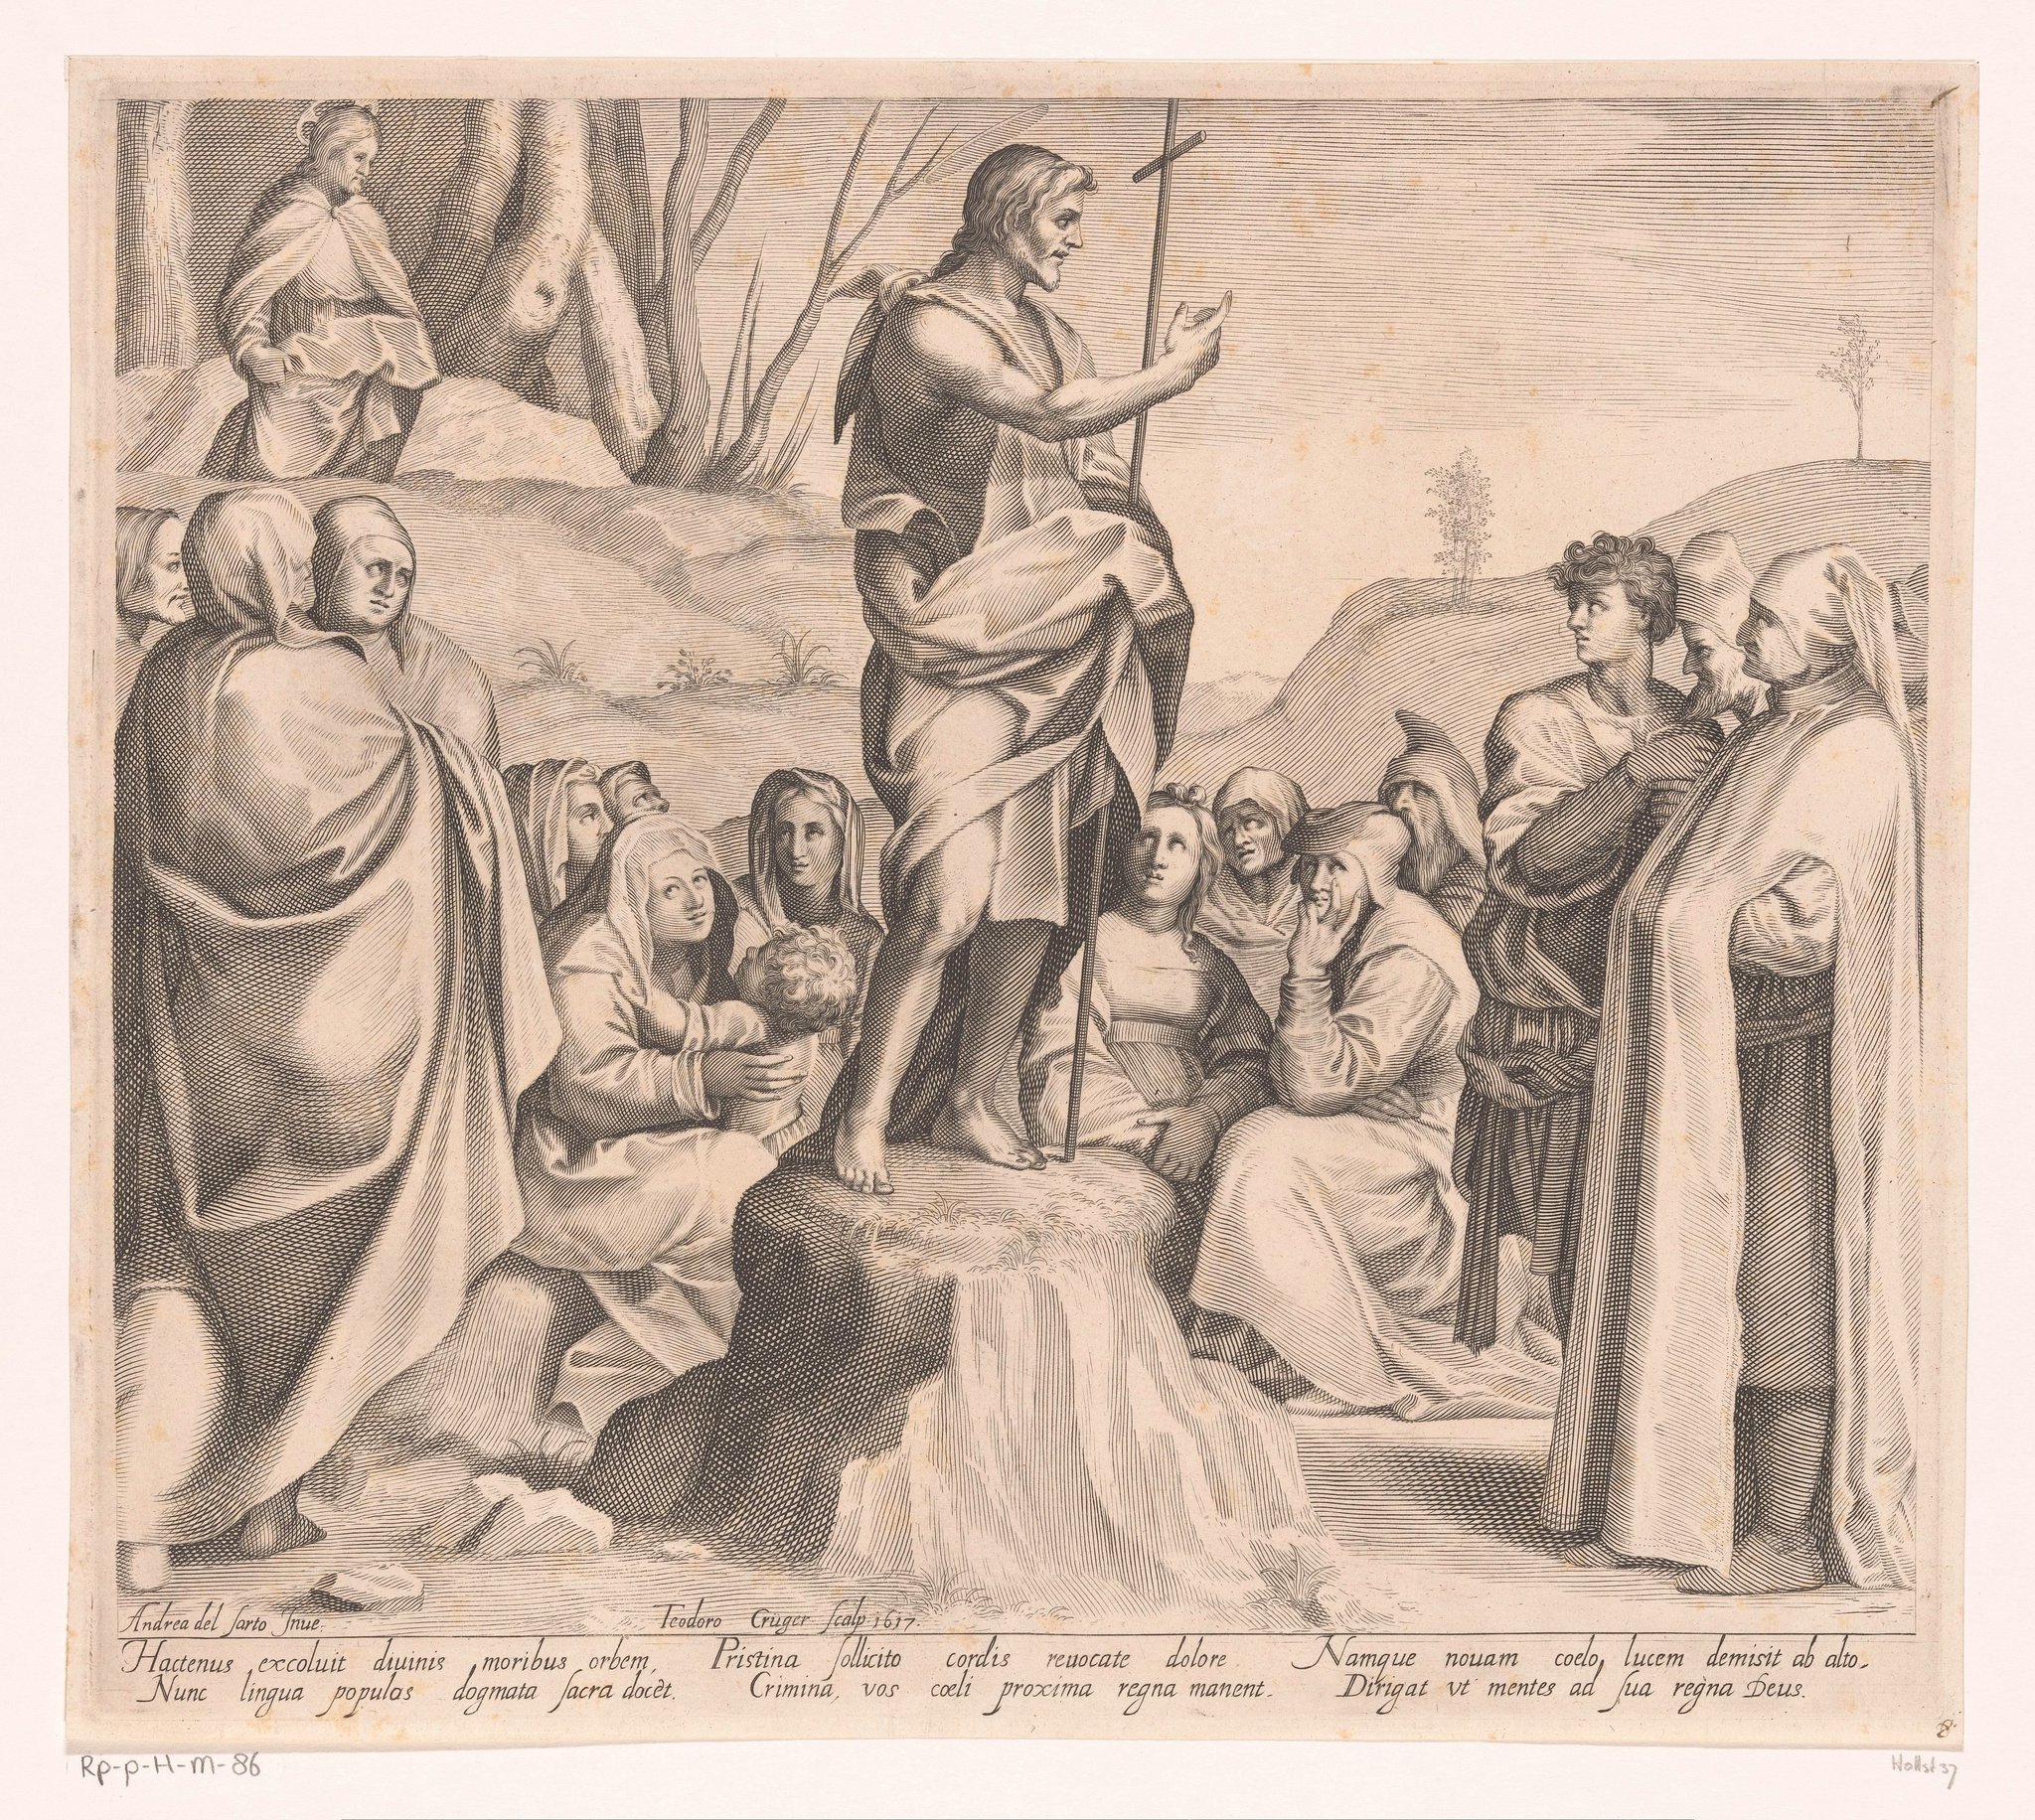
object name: print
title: Scènes uit het leven van Johannes de Doper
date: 1617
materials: paper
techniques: engraving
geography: florence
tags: john the baptist preaching (perhaps christ among the bystanders)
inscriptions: collector's mark: Lugt 11, collector's mark: ‘Hinloopen’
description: Onderdeel van een serie van dertien prenten en een titelprent. Origineel onderdeel geweest van het album Schijnvoet-nummer 24.